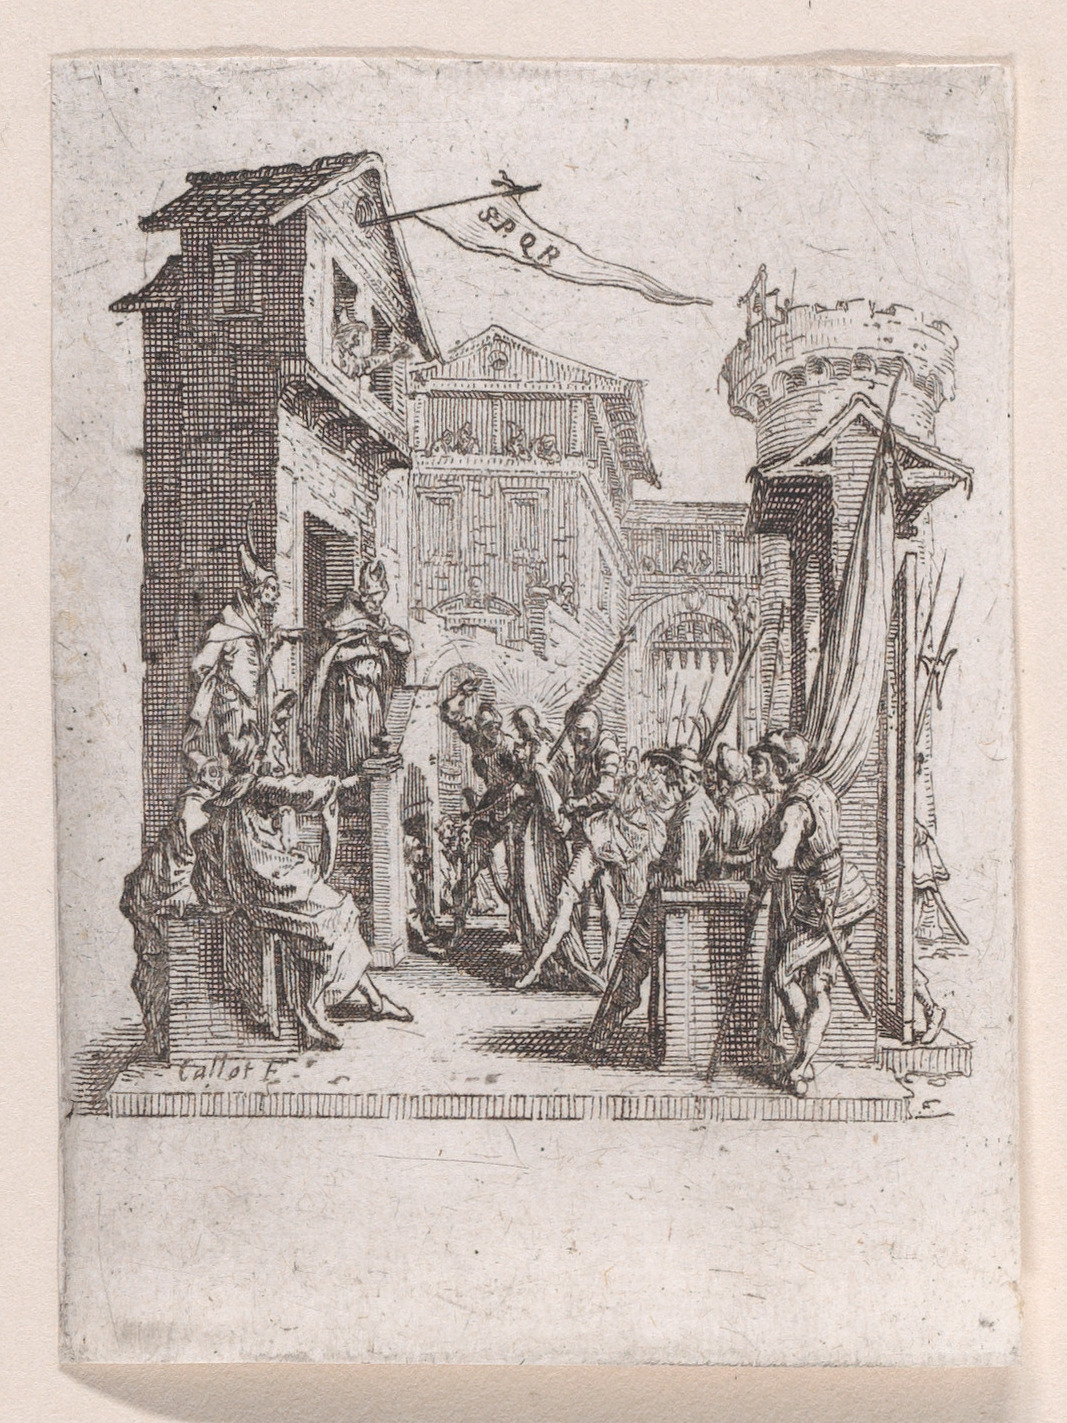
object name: print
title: Jésus Comparait Devant Caiphe (Jesus Appears Before Caiaphas), from "La Petite Passion" (The Little Passion)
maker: jacques callot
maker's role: artist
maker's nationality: french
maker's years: 1592-1635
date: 1624-1625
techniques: etching